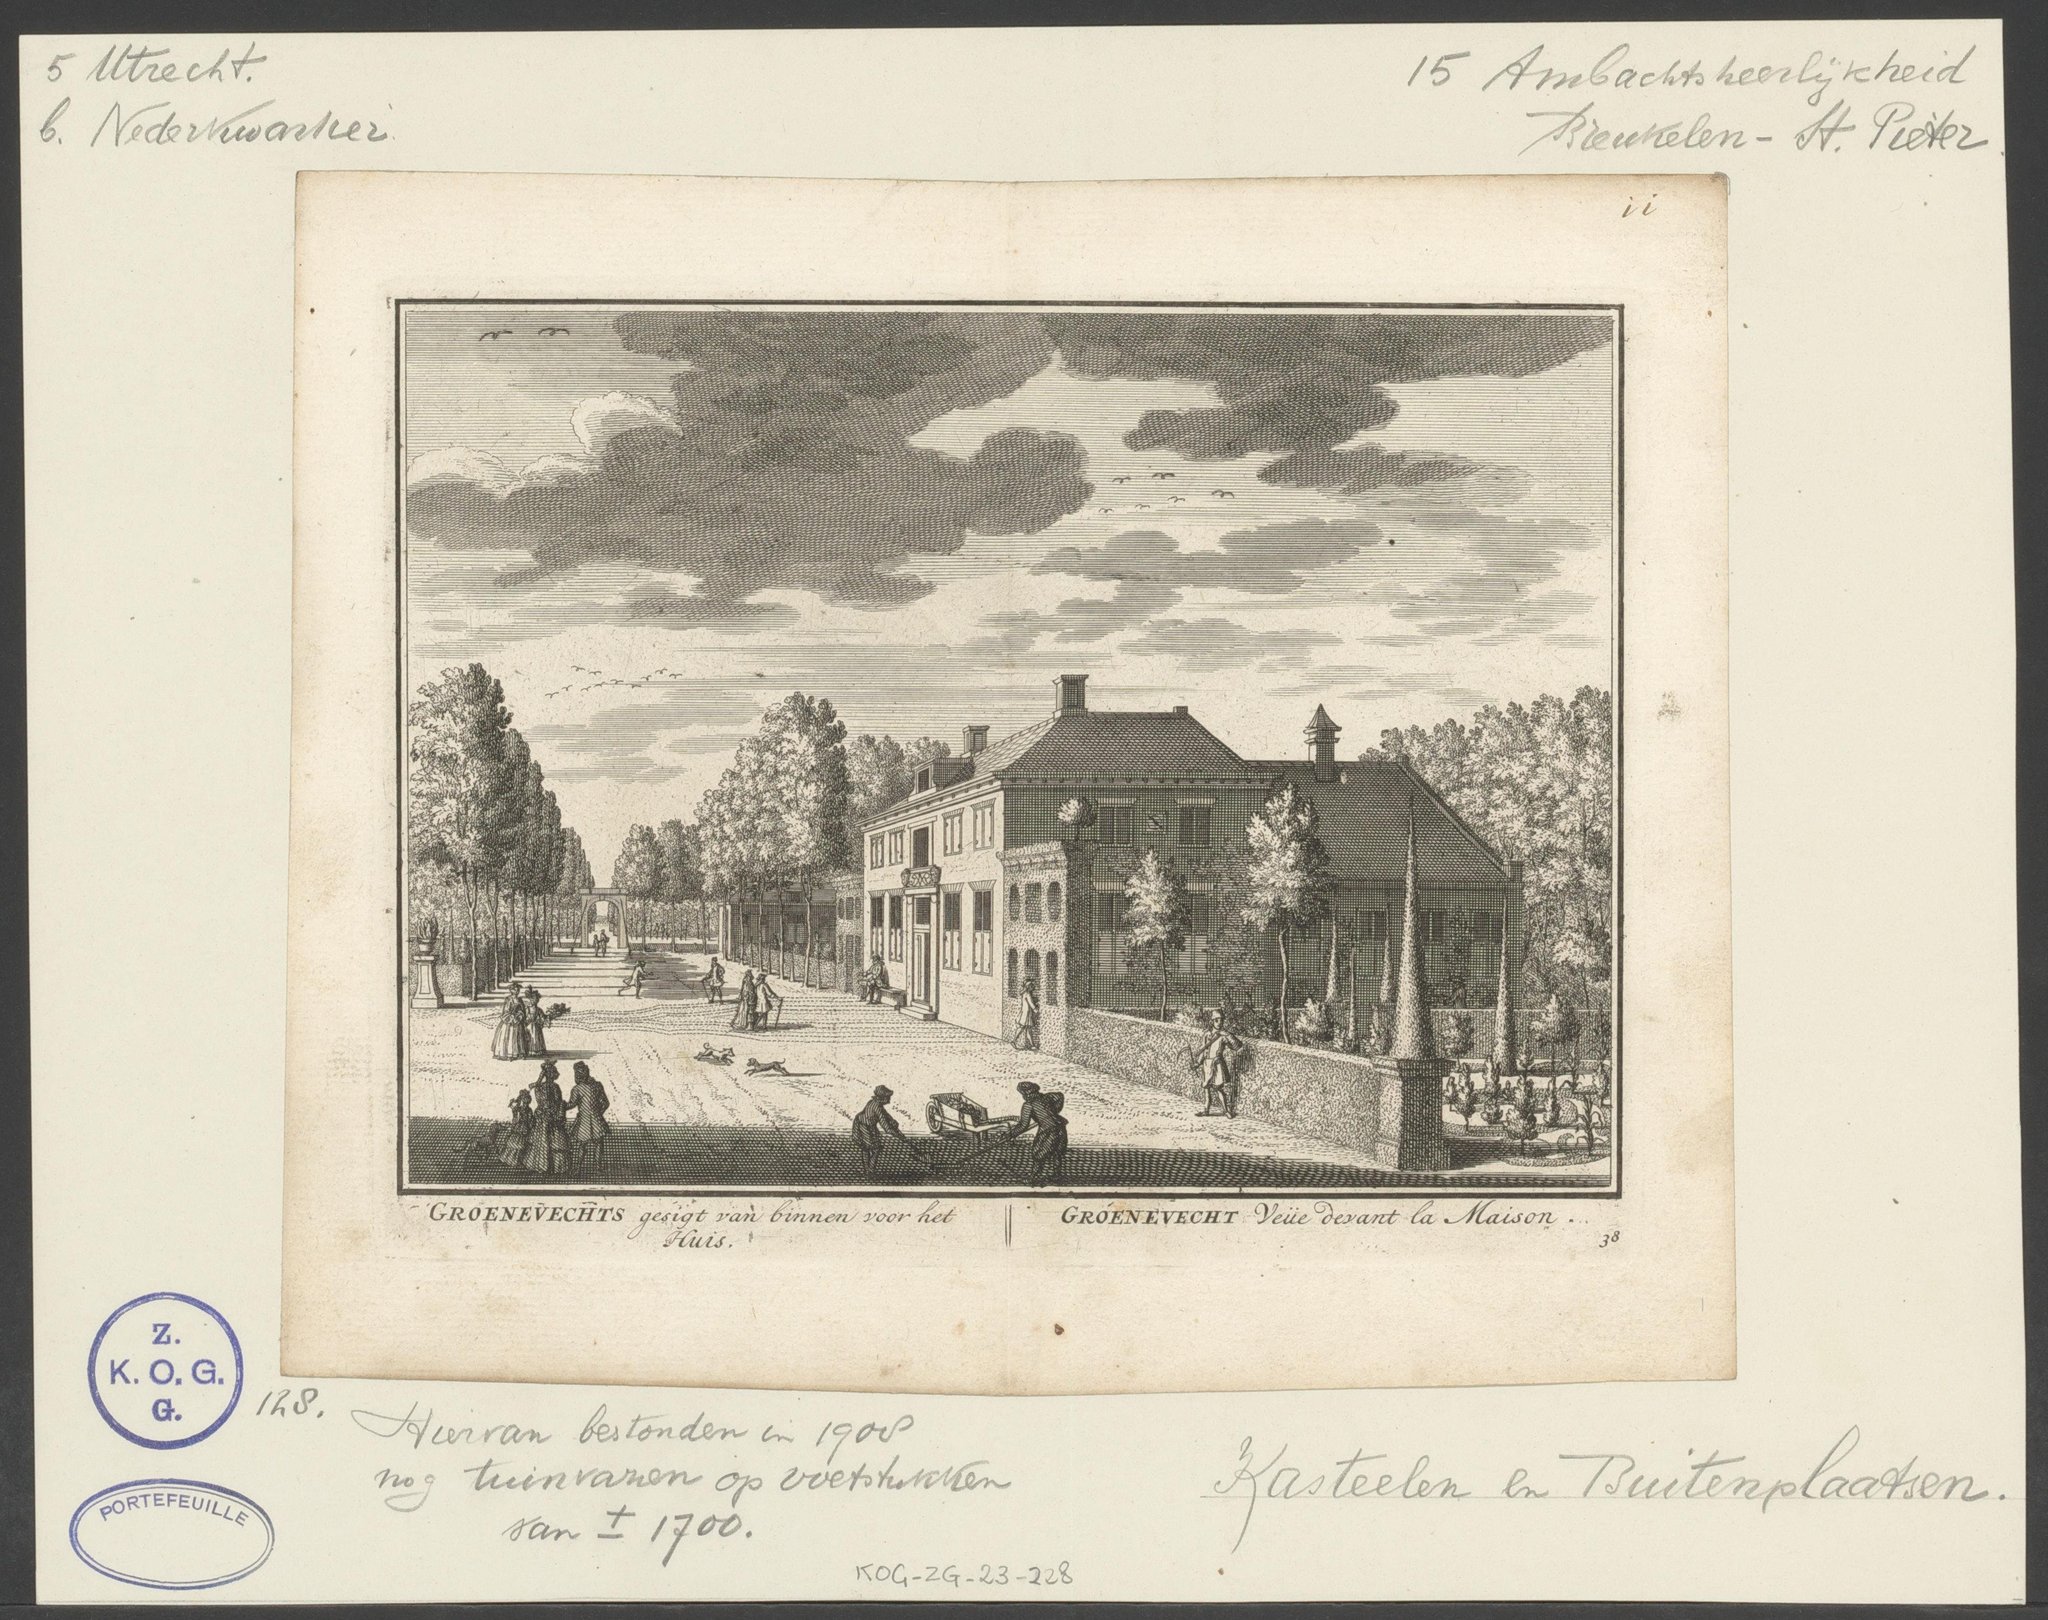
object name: print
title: Groenevechts gesigt van binnen voor het Huis / Groenevecht Veüe devant la Maison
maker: daniël stopendaal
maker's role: print maker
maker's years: 1672-1726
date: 1790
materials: paper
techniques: engraving, etching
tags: country-house, vecht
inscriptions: collector's mark: Lugt 1641, stamp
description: Prent voor het eerst gebruikt in: Leth, Andries de. De zegepraalende Vecht, vertoonende verscheidene gesichten van lustplaatsen, heeren huysen en dorpen, beginnende van Uitrecht en met Muyden besluytende (...). Amsterdam: Weduwe Nicolaus Visscher, 1719. Prent mogelijk uit: Brouërius van Nidek, Matthaeus. De Vechtstroom, van Utrecht tot Muiden (...). Amsterdam: H. Gartman, W. Vermandel en J.W. Smit, 1790.